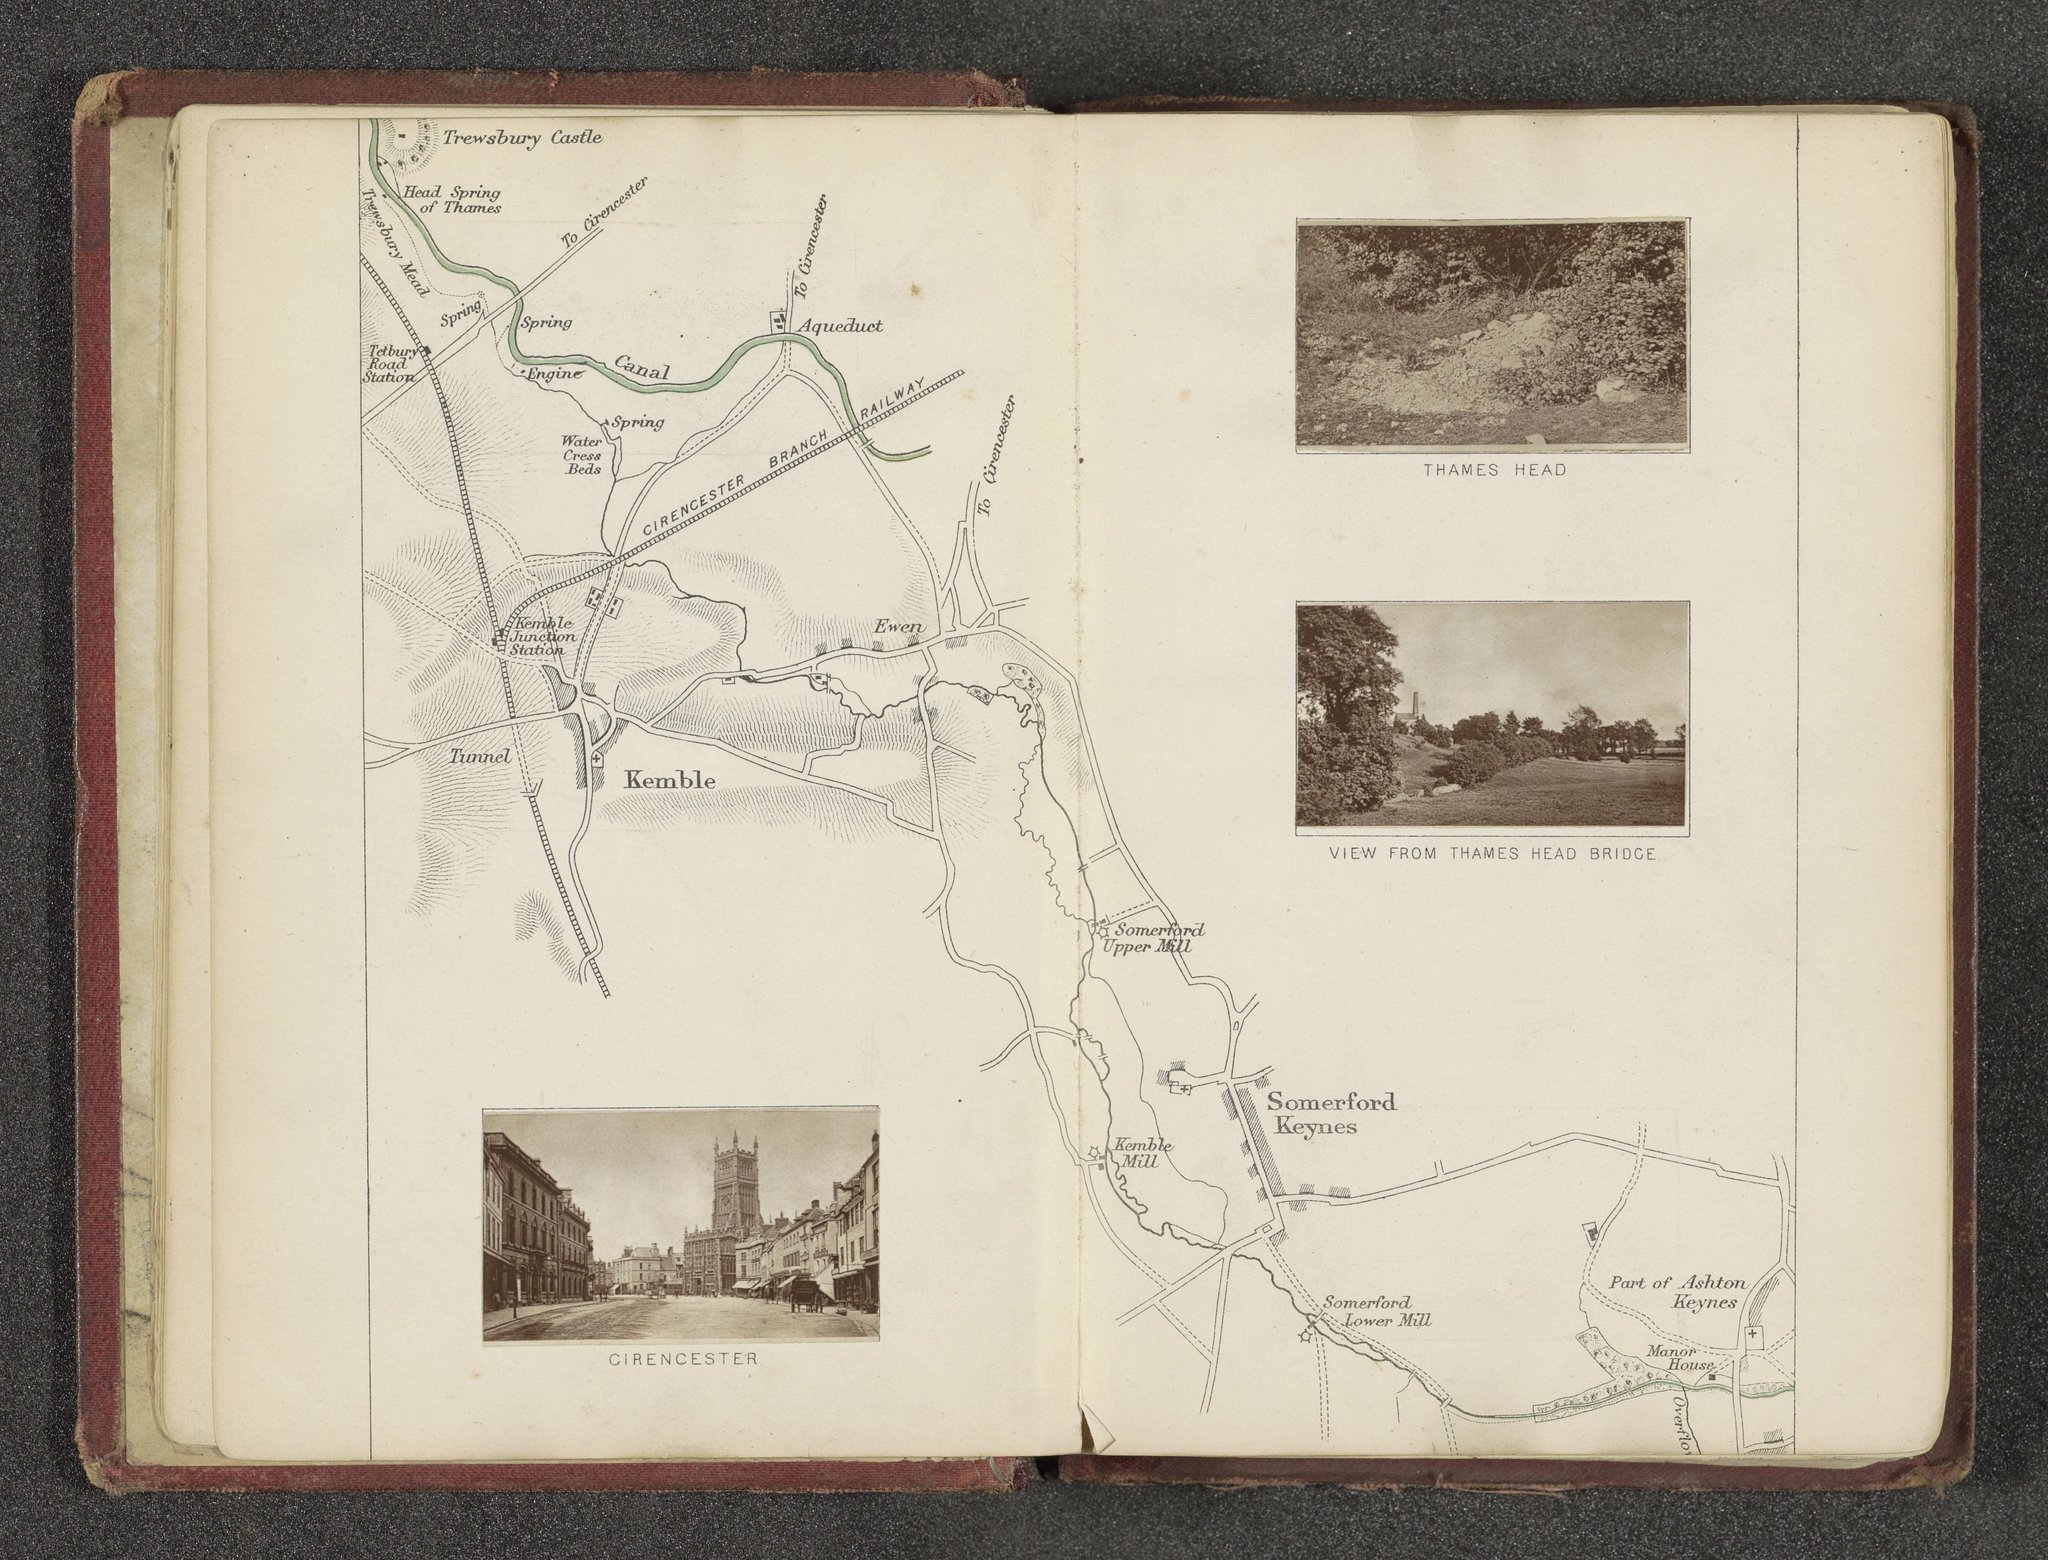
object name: page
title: Kaart met drie afbeeldingen van plaatsen langs de Theems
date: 1878-1879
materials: paper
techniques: engraving, woodburytype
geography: gloucestershire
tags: river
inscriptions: inscription: ‘Cirencester Thames head View from Thames head bridge’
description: Links: gezicht op Cirencester, rechts: twee afbeeldingen van Thames Head, van oudsher bekend als de bron van de Theems.